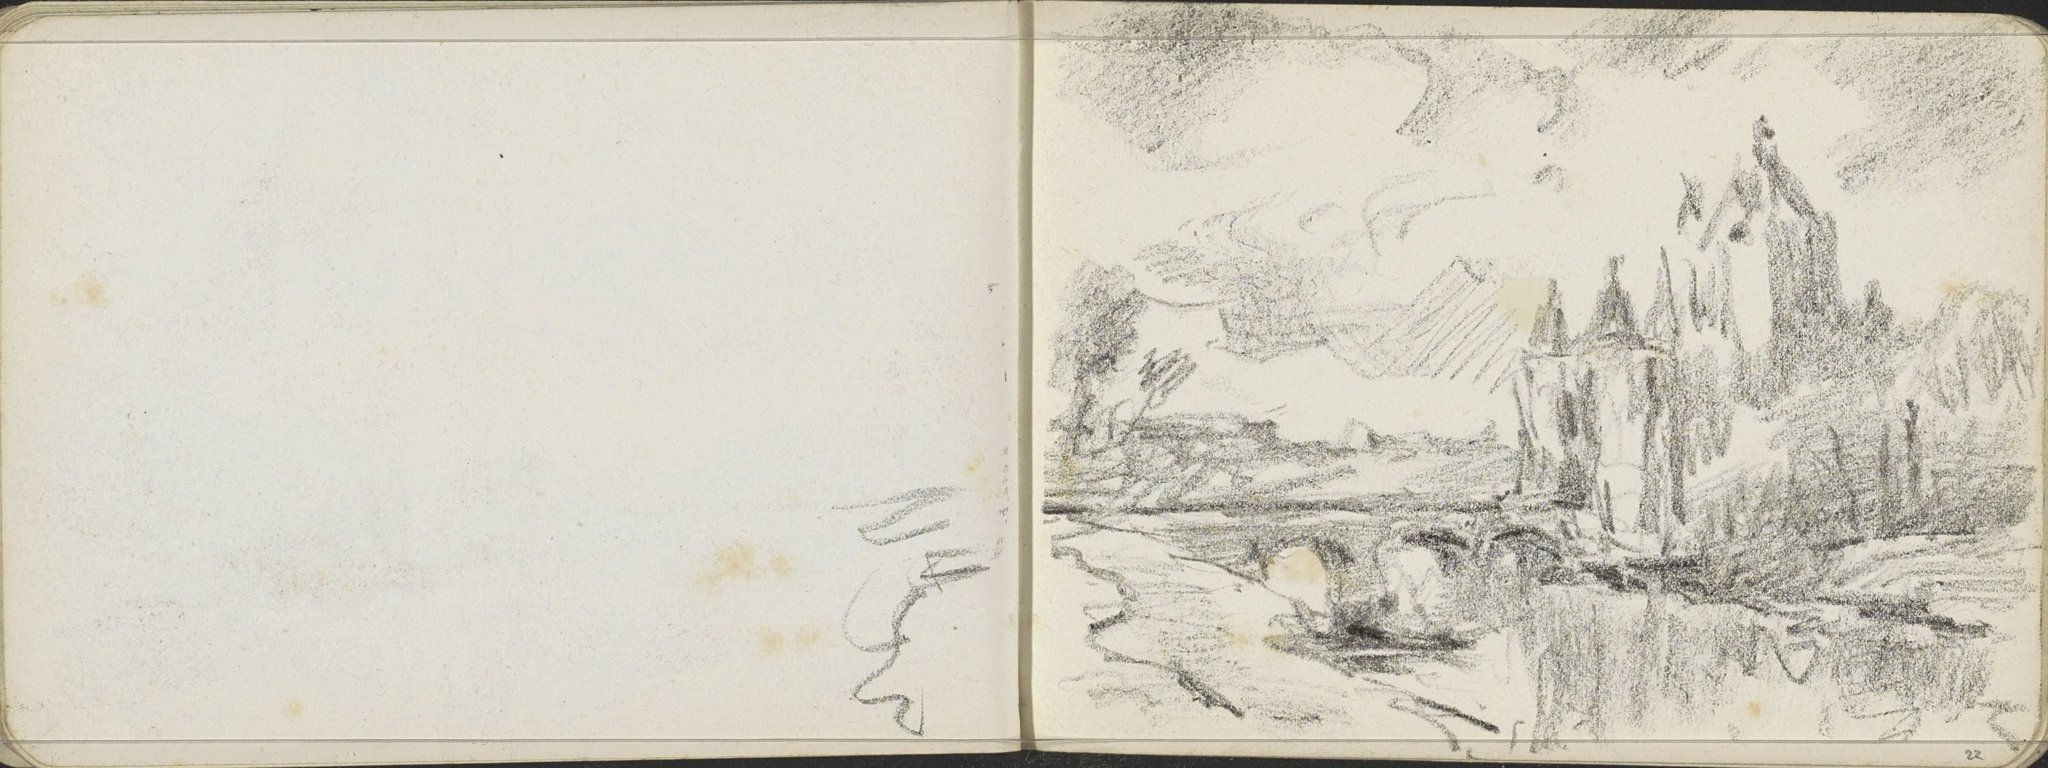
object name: sketchbook leaf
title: Amsterdamse Poort te Haarlem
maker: willem cornelis rip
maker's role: draughtsman, painter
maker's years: 1856-1922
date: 1907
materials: chalk, paper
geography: haarlem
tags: towers ~ fortified city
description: Blad 21 verso en 22 recto uit een schetsboek met 41 bladen.